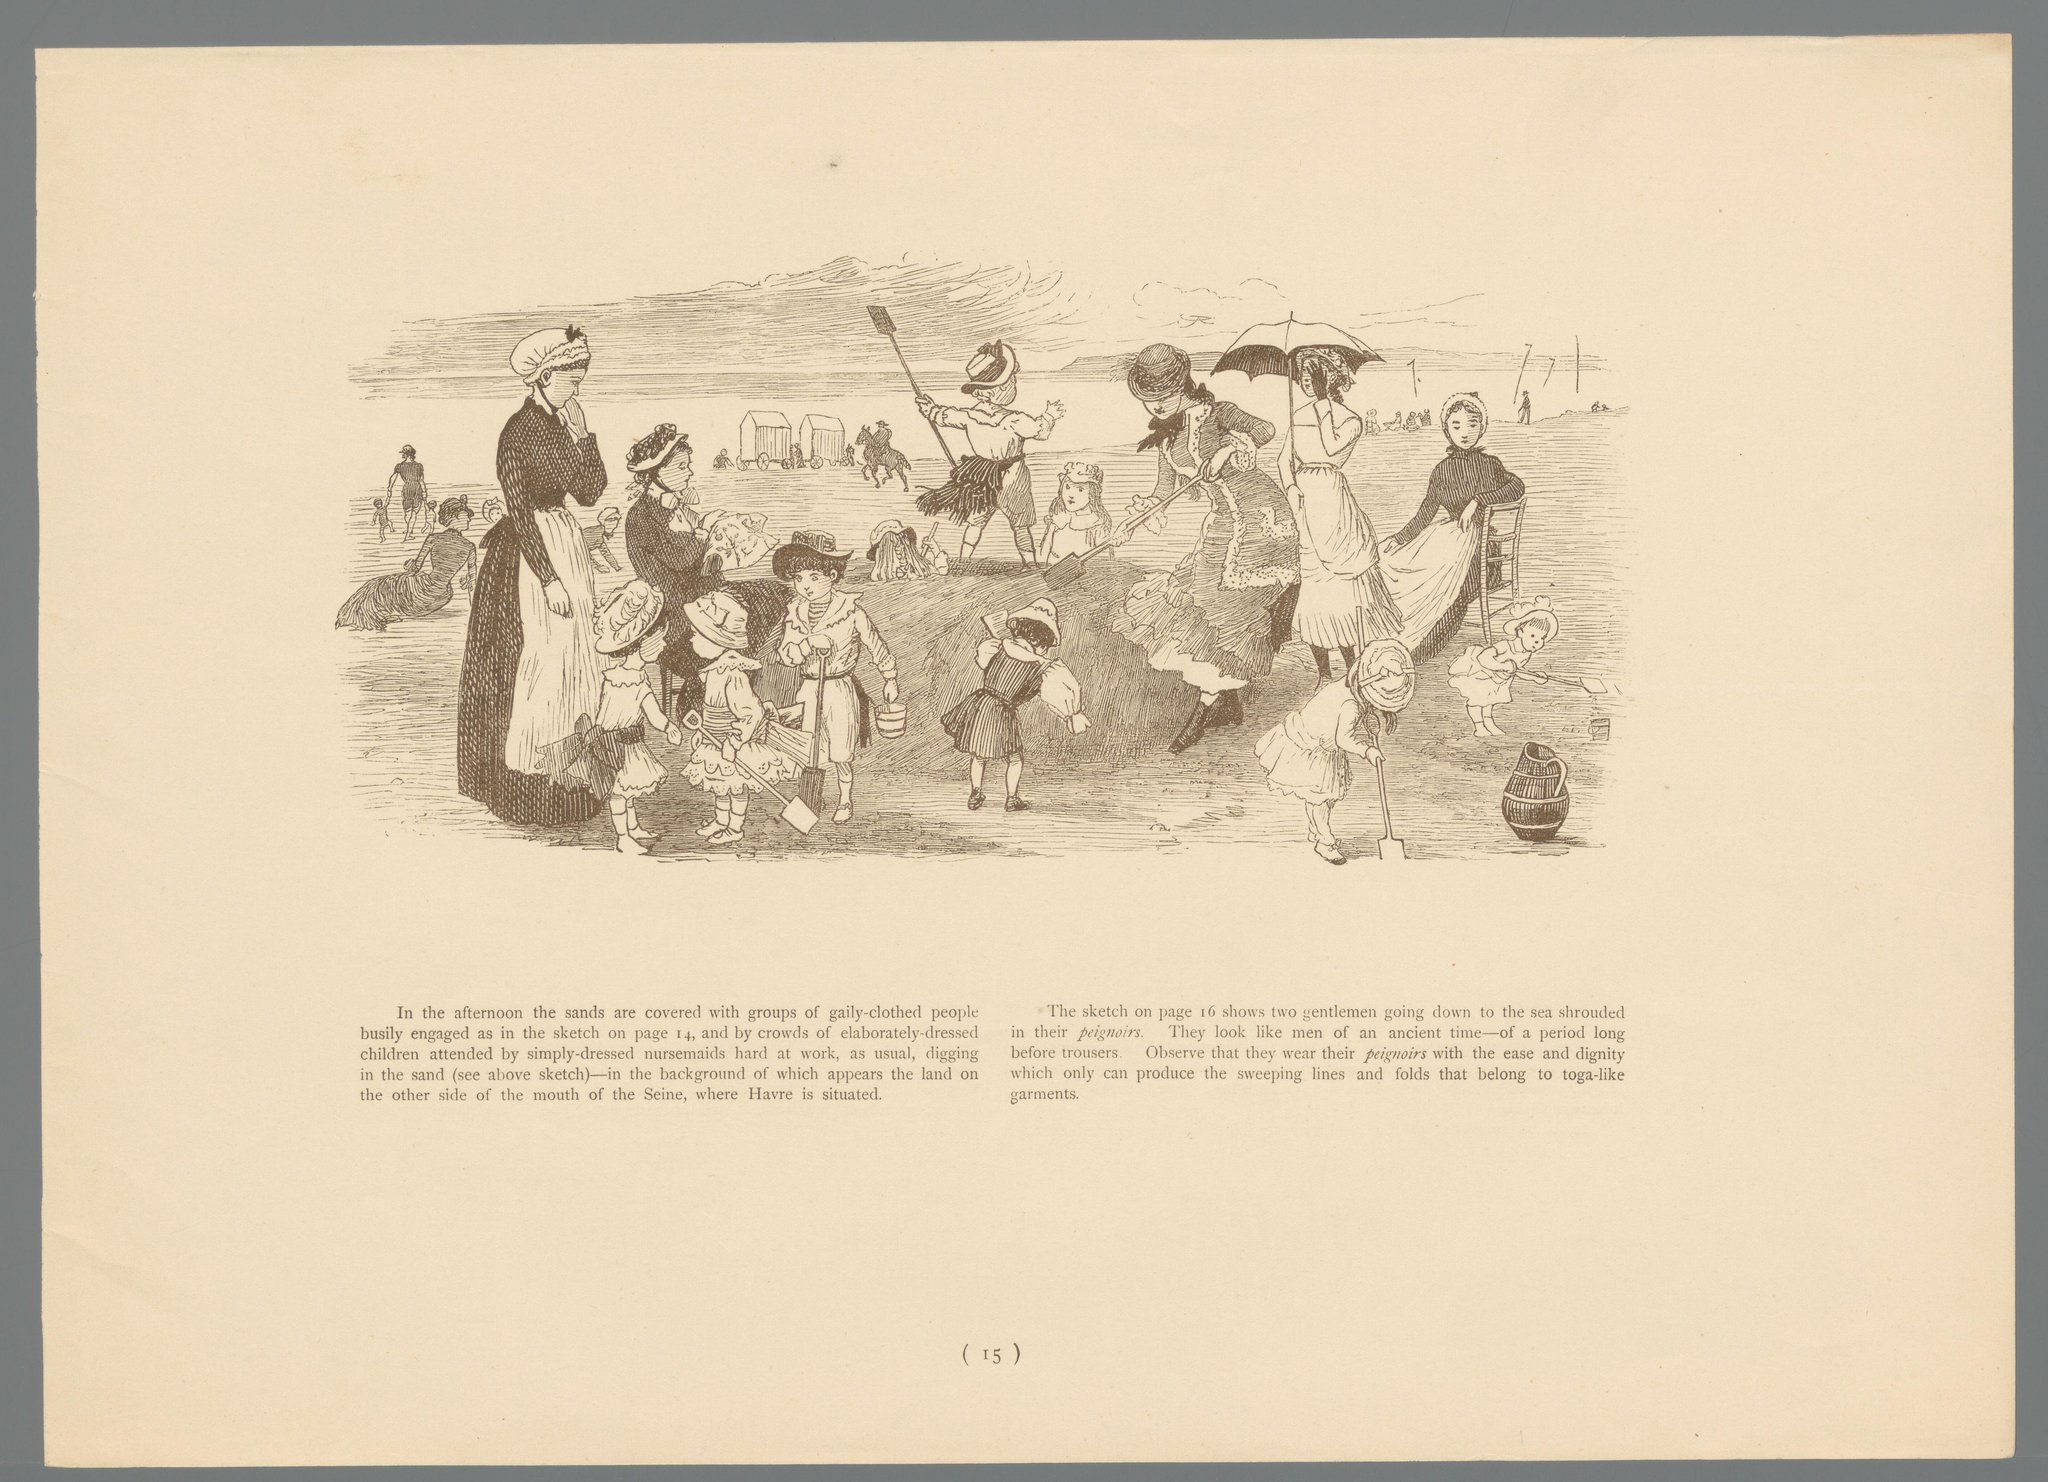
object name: book illustration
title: Vrouwen en kinderen maken een berg met strandzand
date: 1889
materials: paper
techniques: letterpress printing, engraving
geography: london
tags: beach (as place of recreation), child (+ more than eight persons), (building) sand-castle, coast (+ landscape with figures, staffage)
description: Prent uit: Gleanings from the Graphic. Londen: George Routledge & Sons, 1889. Dit werk is een bundel van diverse illustraties die eerder verschenen in verschillende jaargangen van het Engelse weekblad 'The Graphic'. De bundel is na het overlijden van Randolph Caldecott uitgegeven.